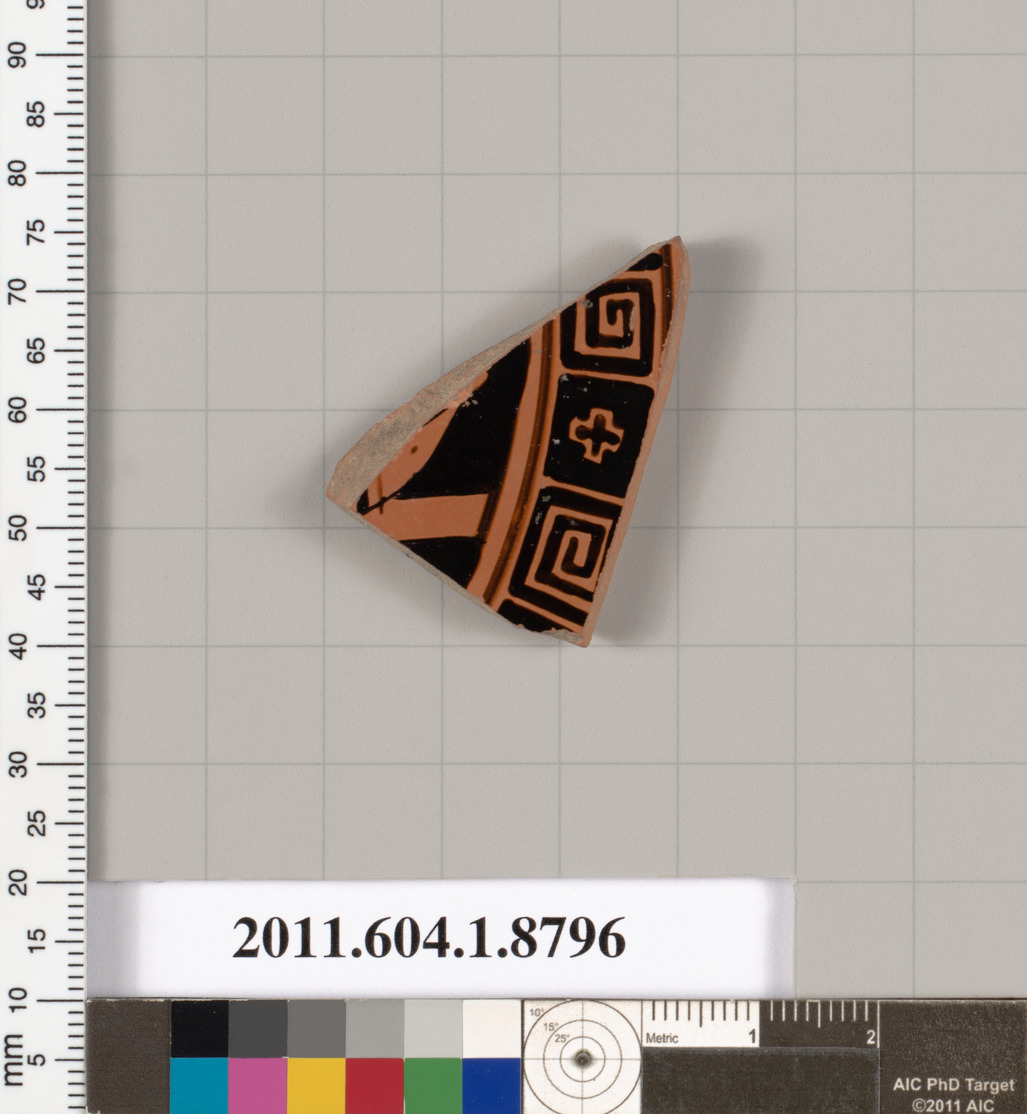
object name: kylix fragment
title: Terracotta fragment of a kylix (drinking cup)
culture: greek, attic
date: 490-480 BCE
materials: terracotta